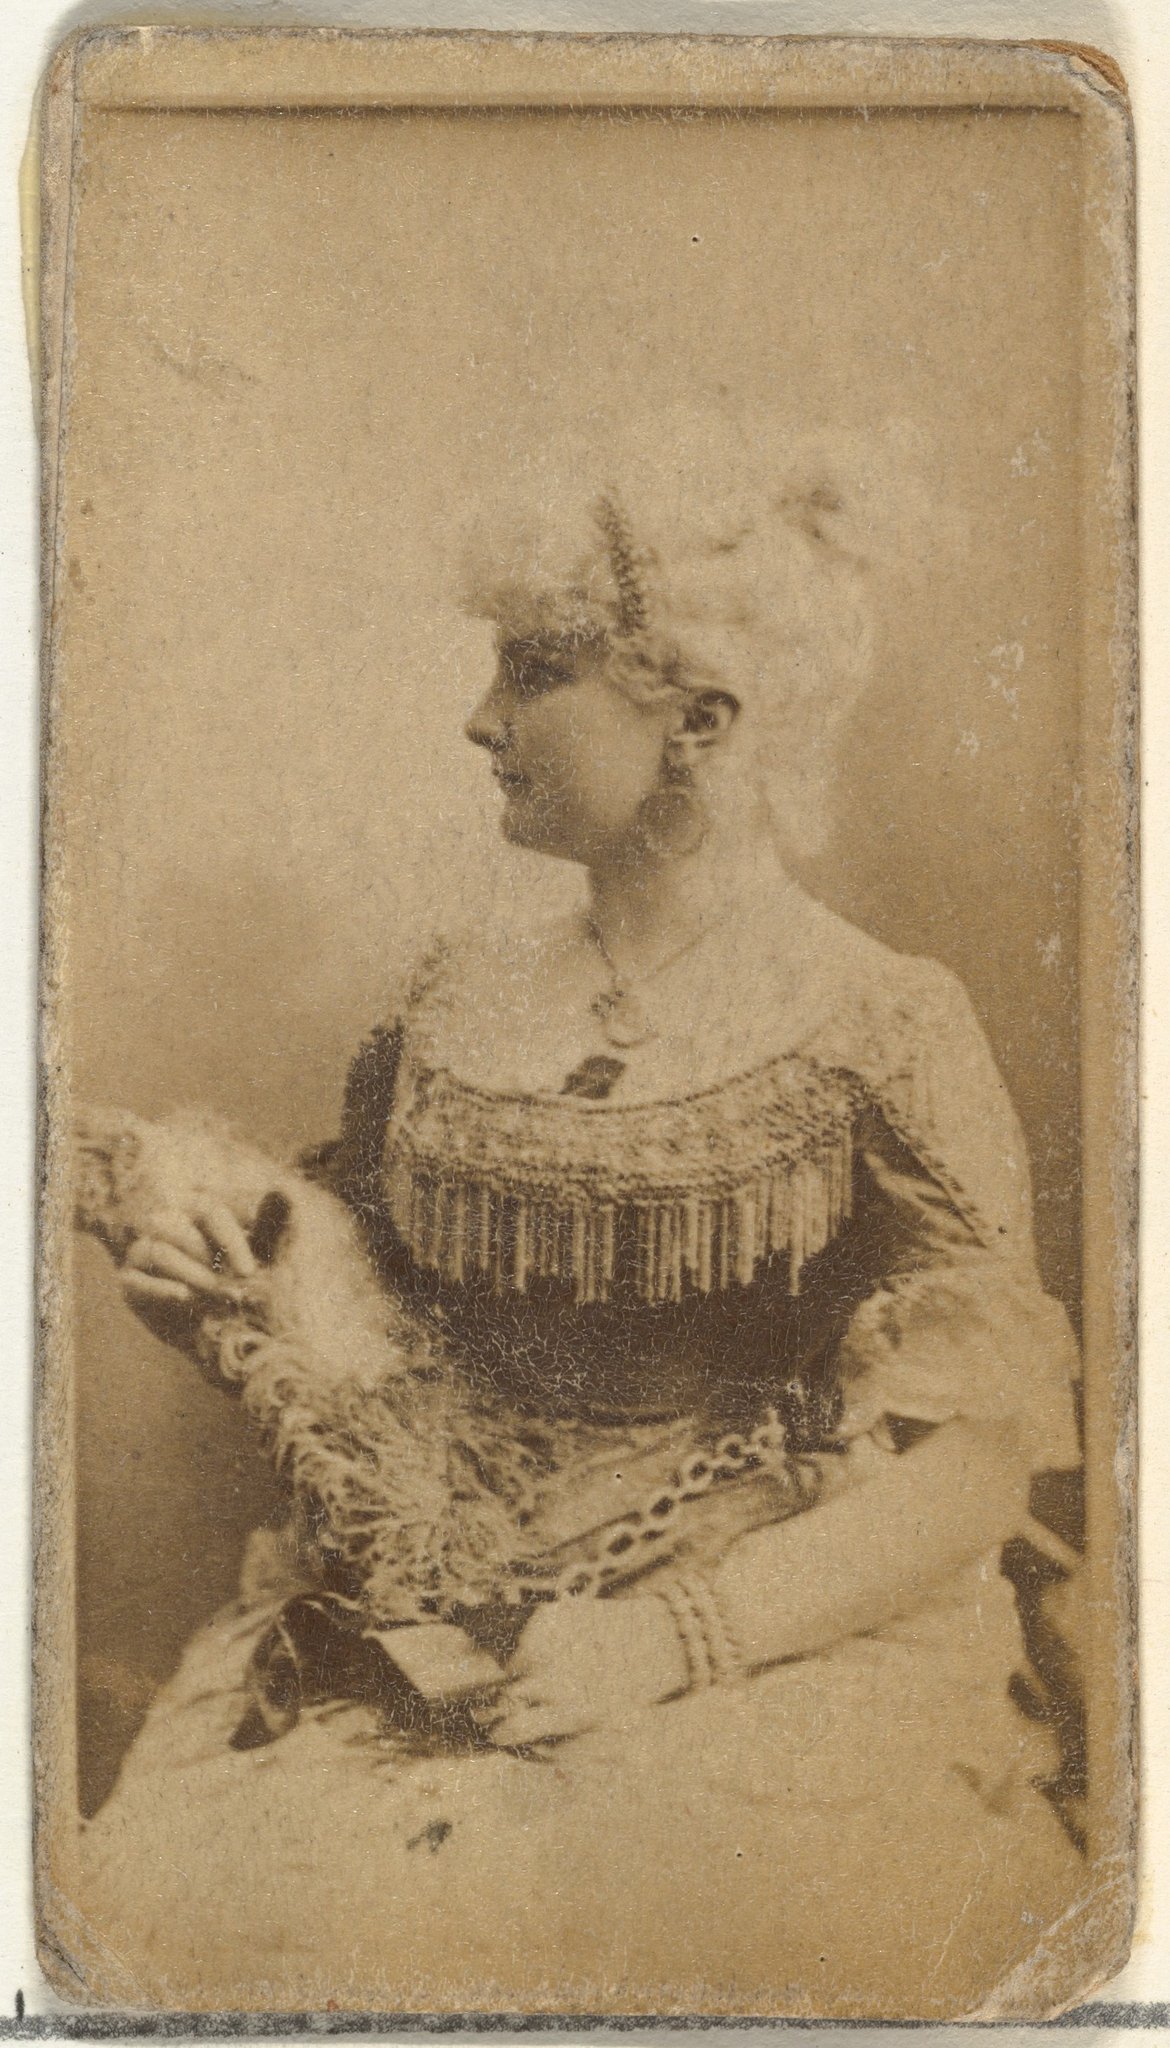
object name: photograph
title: [Actress wearing dress with fringed bodice], from the Actors and Actresses series (N145-8) issued by Duke Sons & Co. to promote Duke Cigarettes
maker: w. duke, sons & co.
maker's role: publisher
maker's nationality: american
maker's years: 1870-1920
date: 1891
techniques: albumen silver print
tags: women,actresses